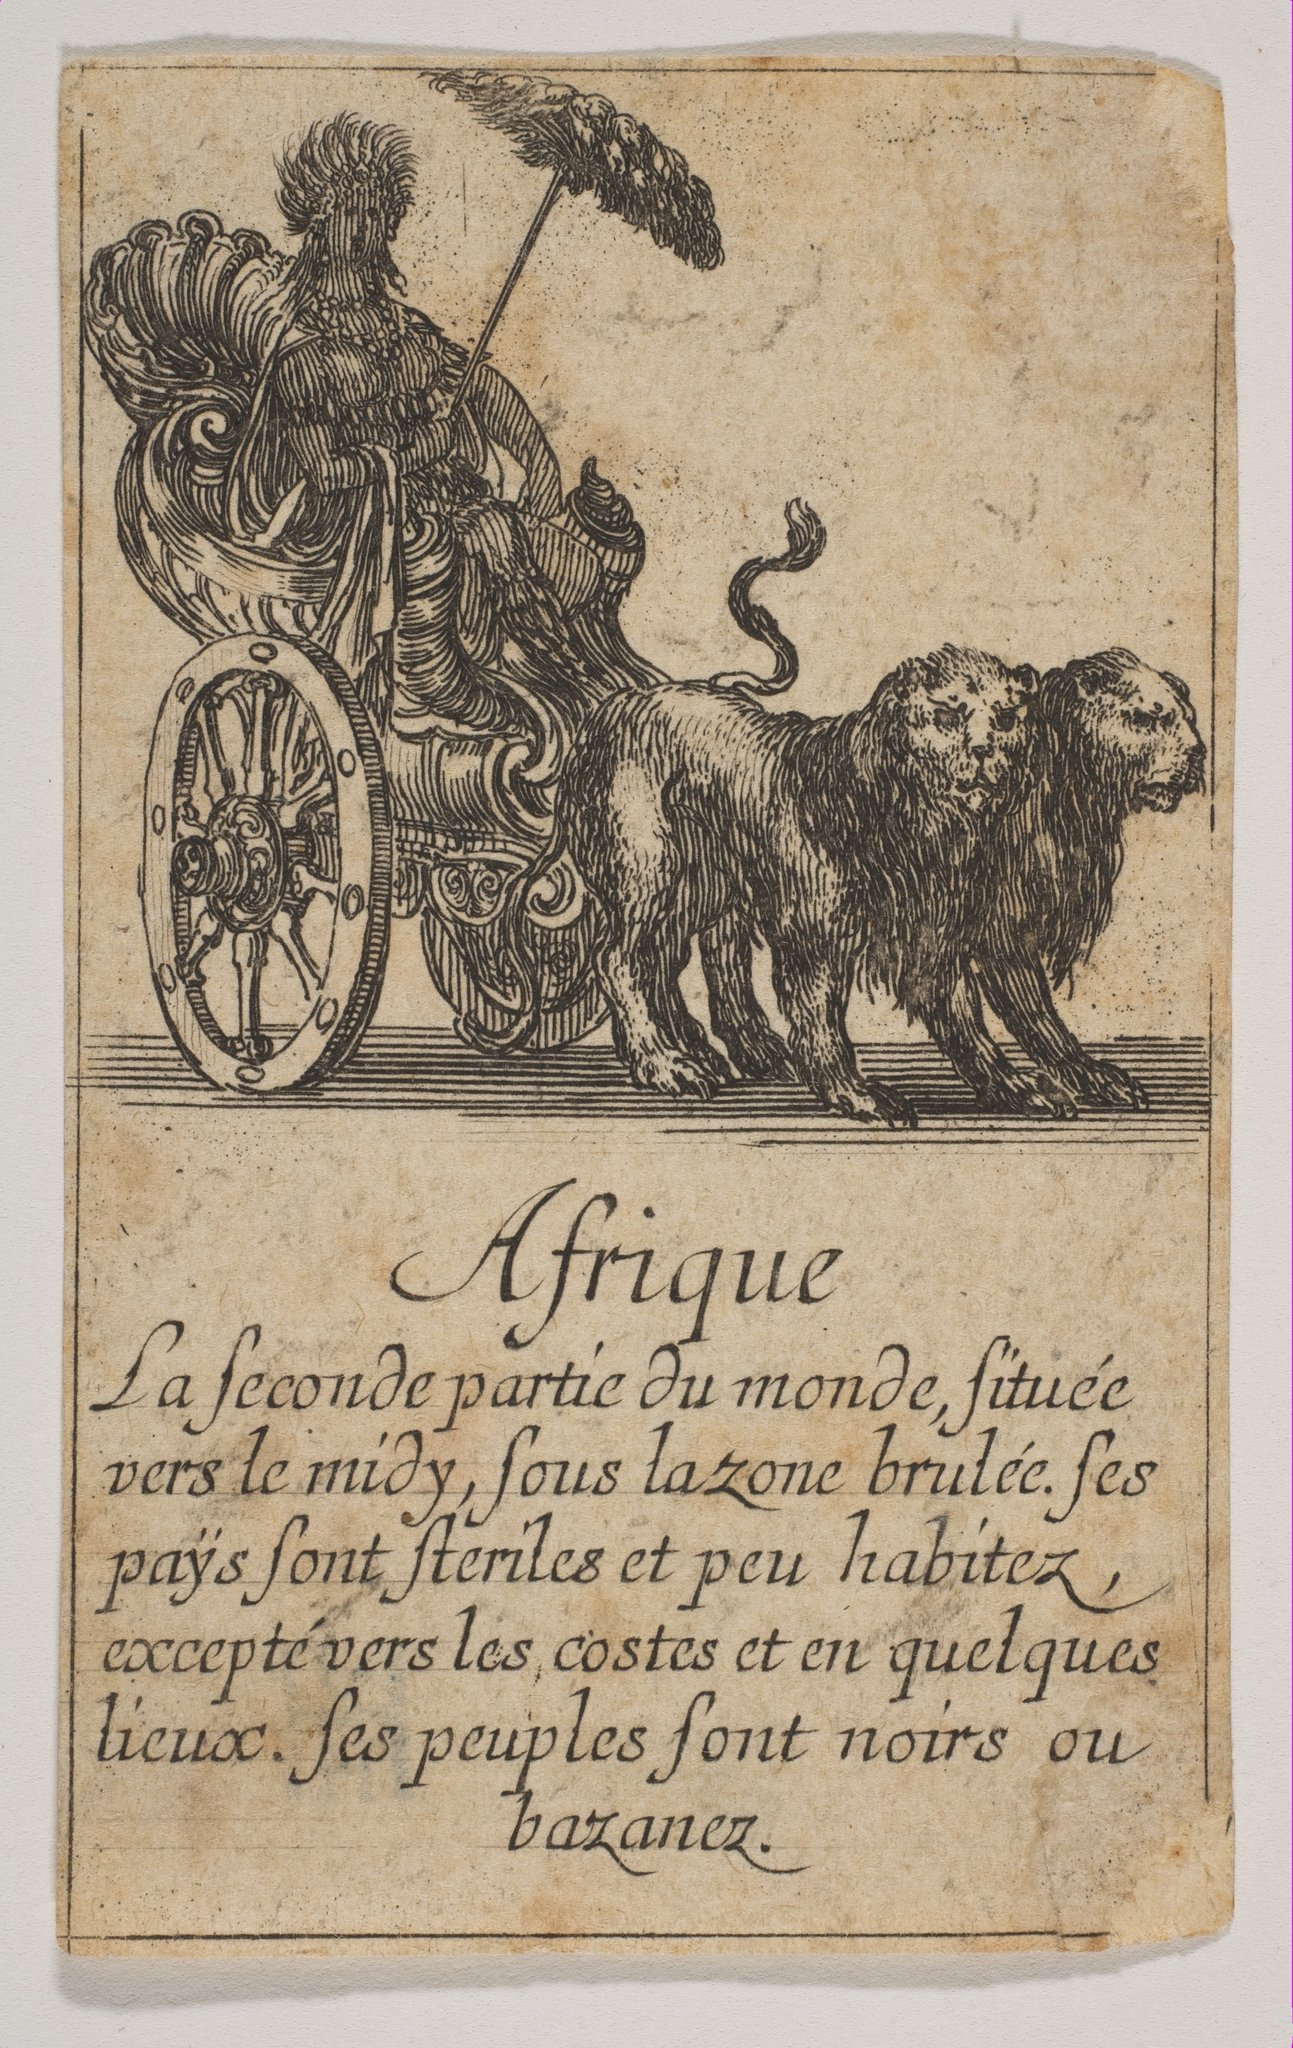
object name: print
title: Afrique, from "Jeu de la Géographie"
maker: stefano della bella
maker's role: artist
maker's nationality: italian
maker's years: 1610-1664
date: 1644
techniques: etching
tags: women,lions,chariots